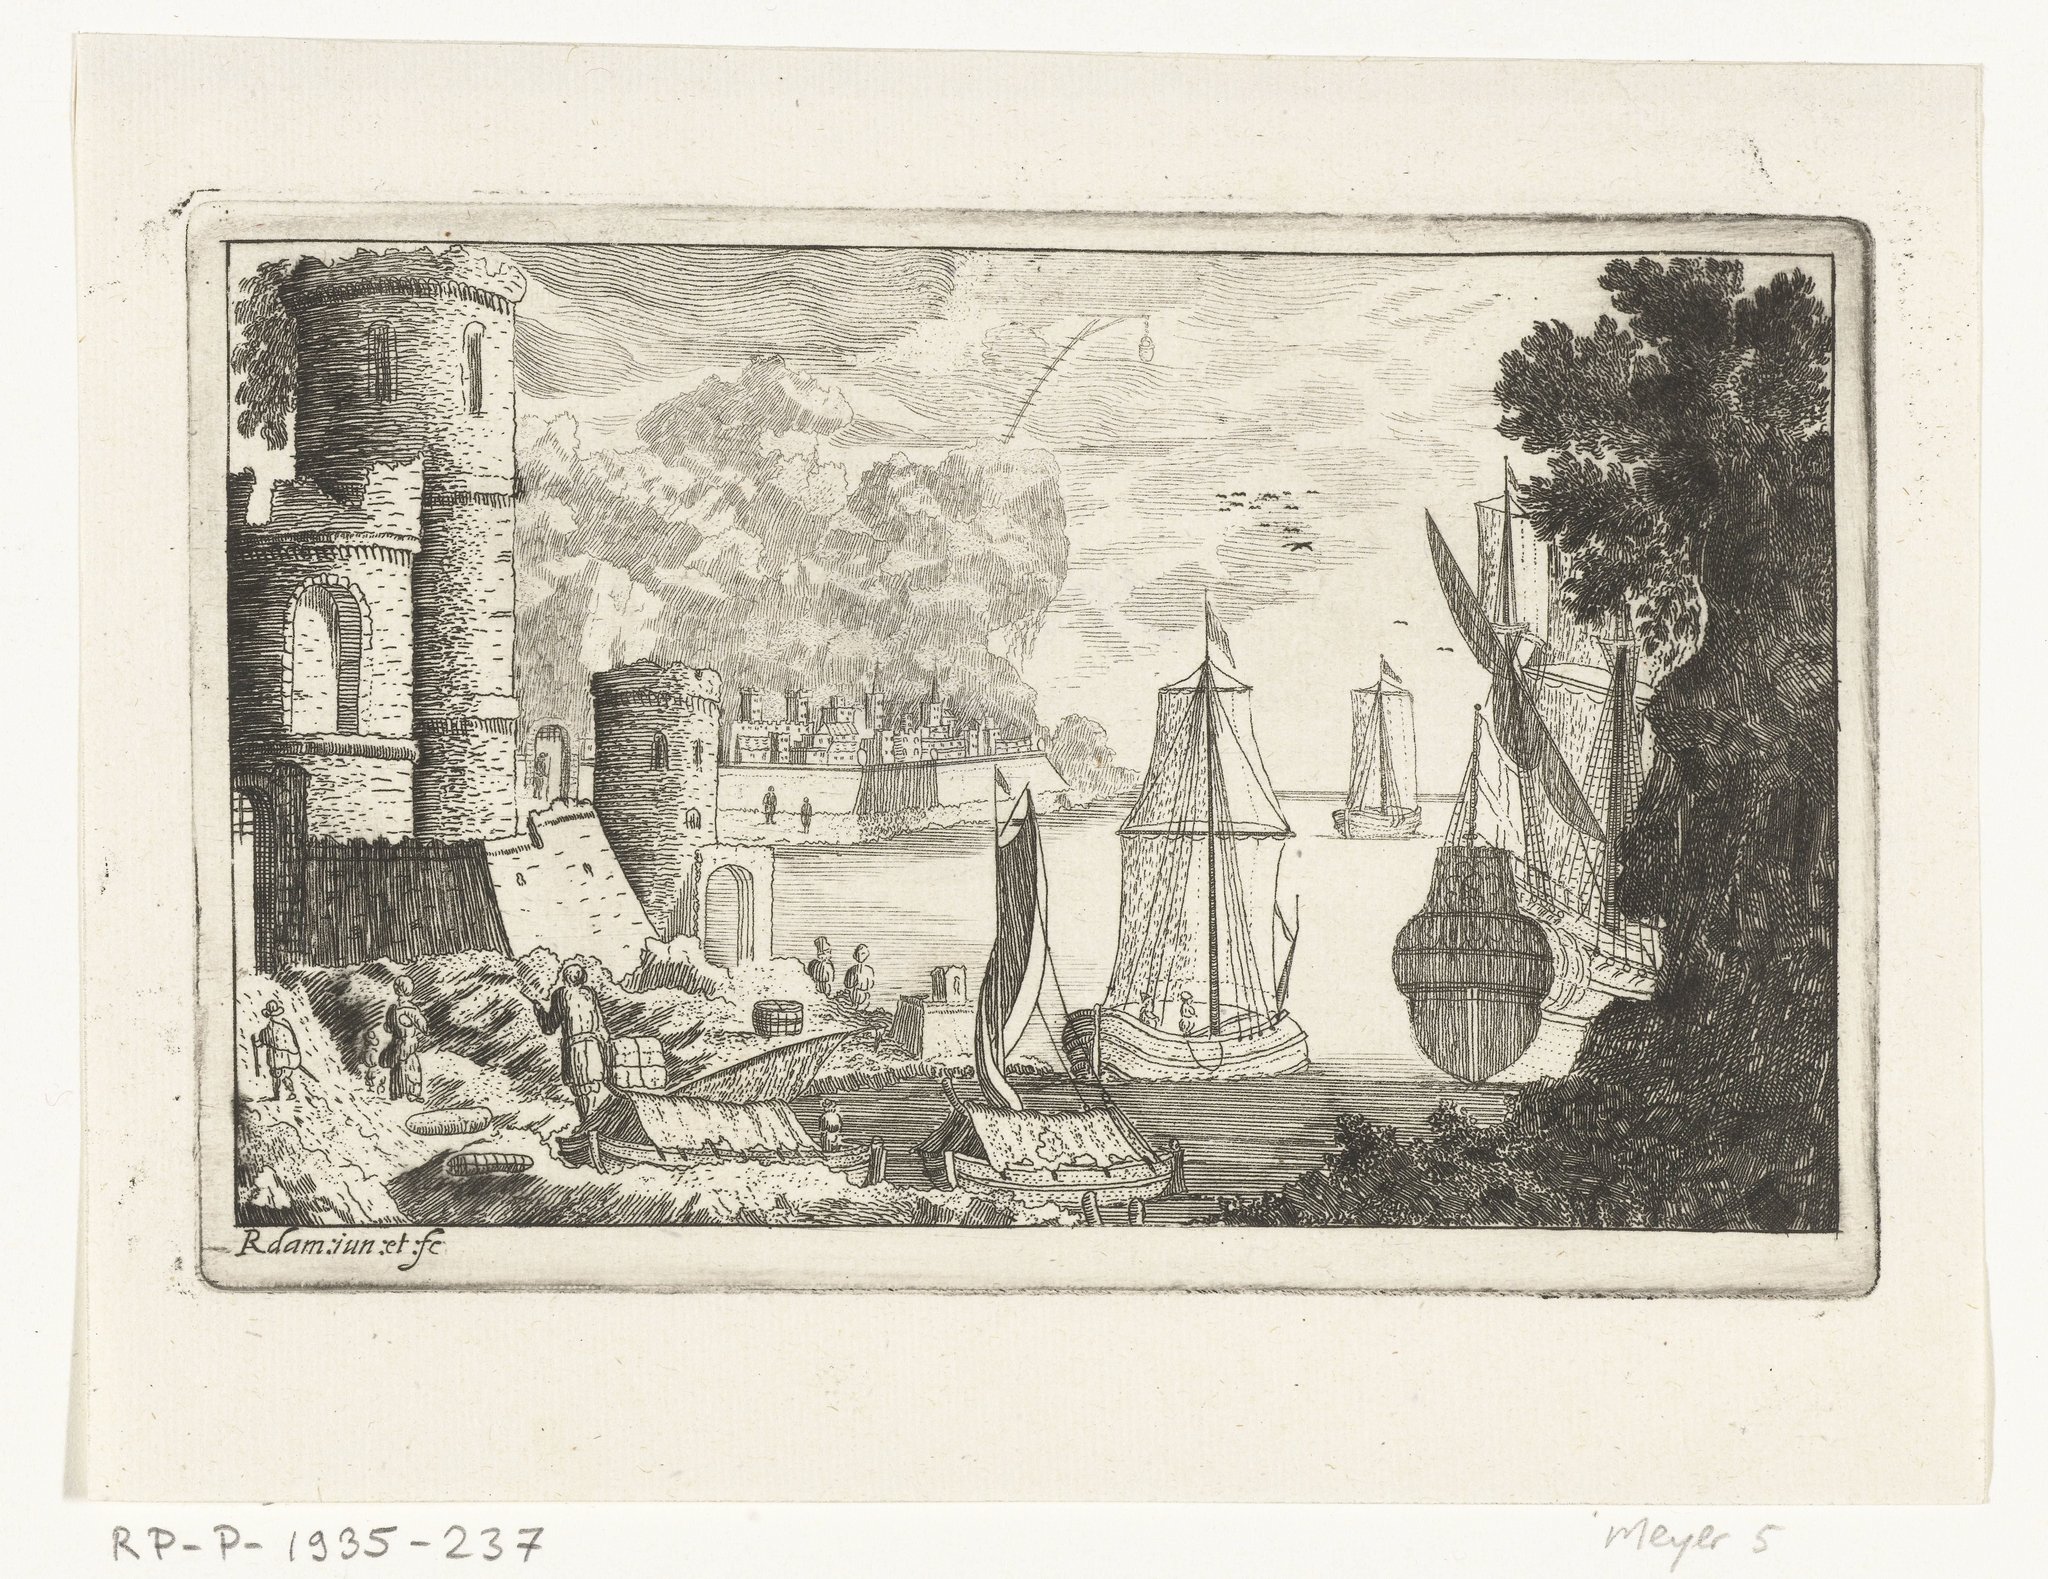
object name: print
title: Haven met lossende boten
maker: richard adam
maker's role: print maker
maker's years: 1644-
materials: paper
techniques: etching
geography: netherlands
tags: harbour, prospect of city, town panorama, silhouette of city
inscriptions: collector's mark: Lugt 2228, collector's mark: Lugt 2760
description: Haven met lossende boten, links een toren. Op de achtergrond grotere schepen en een stad.